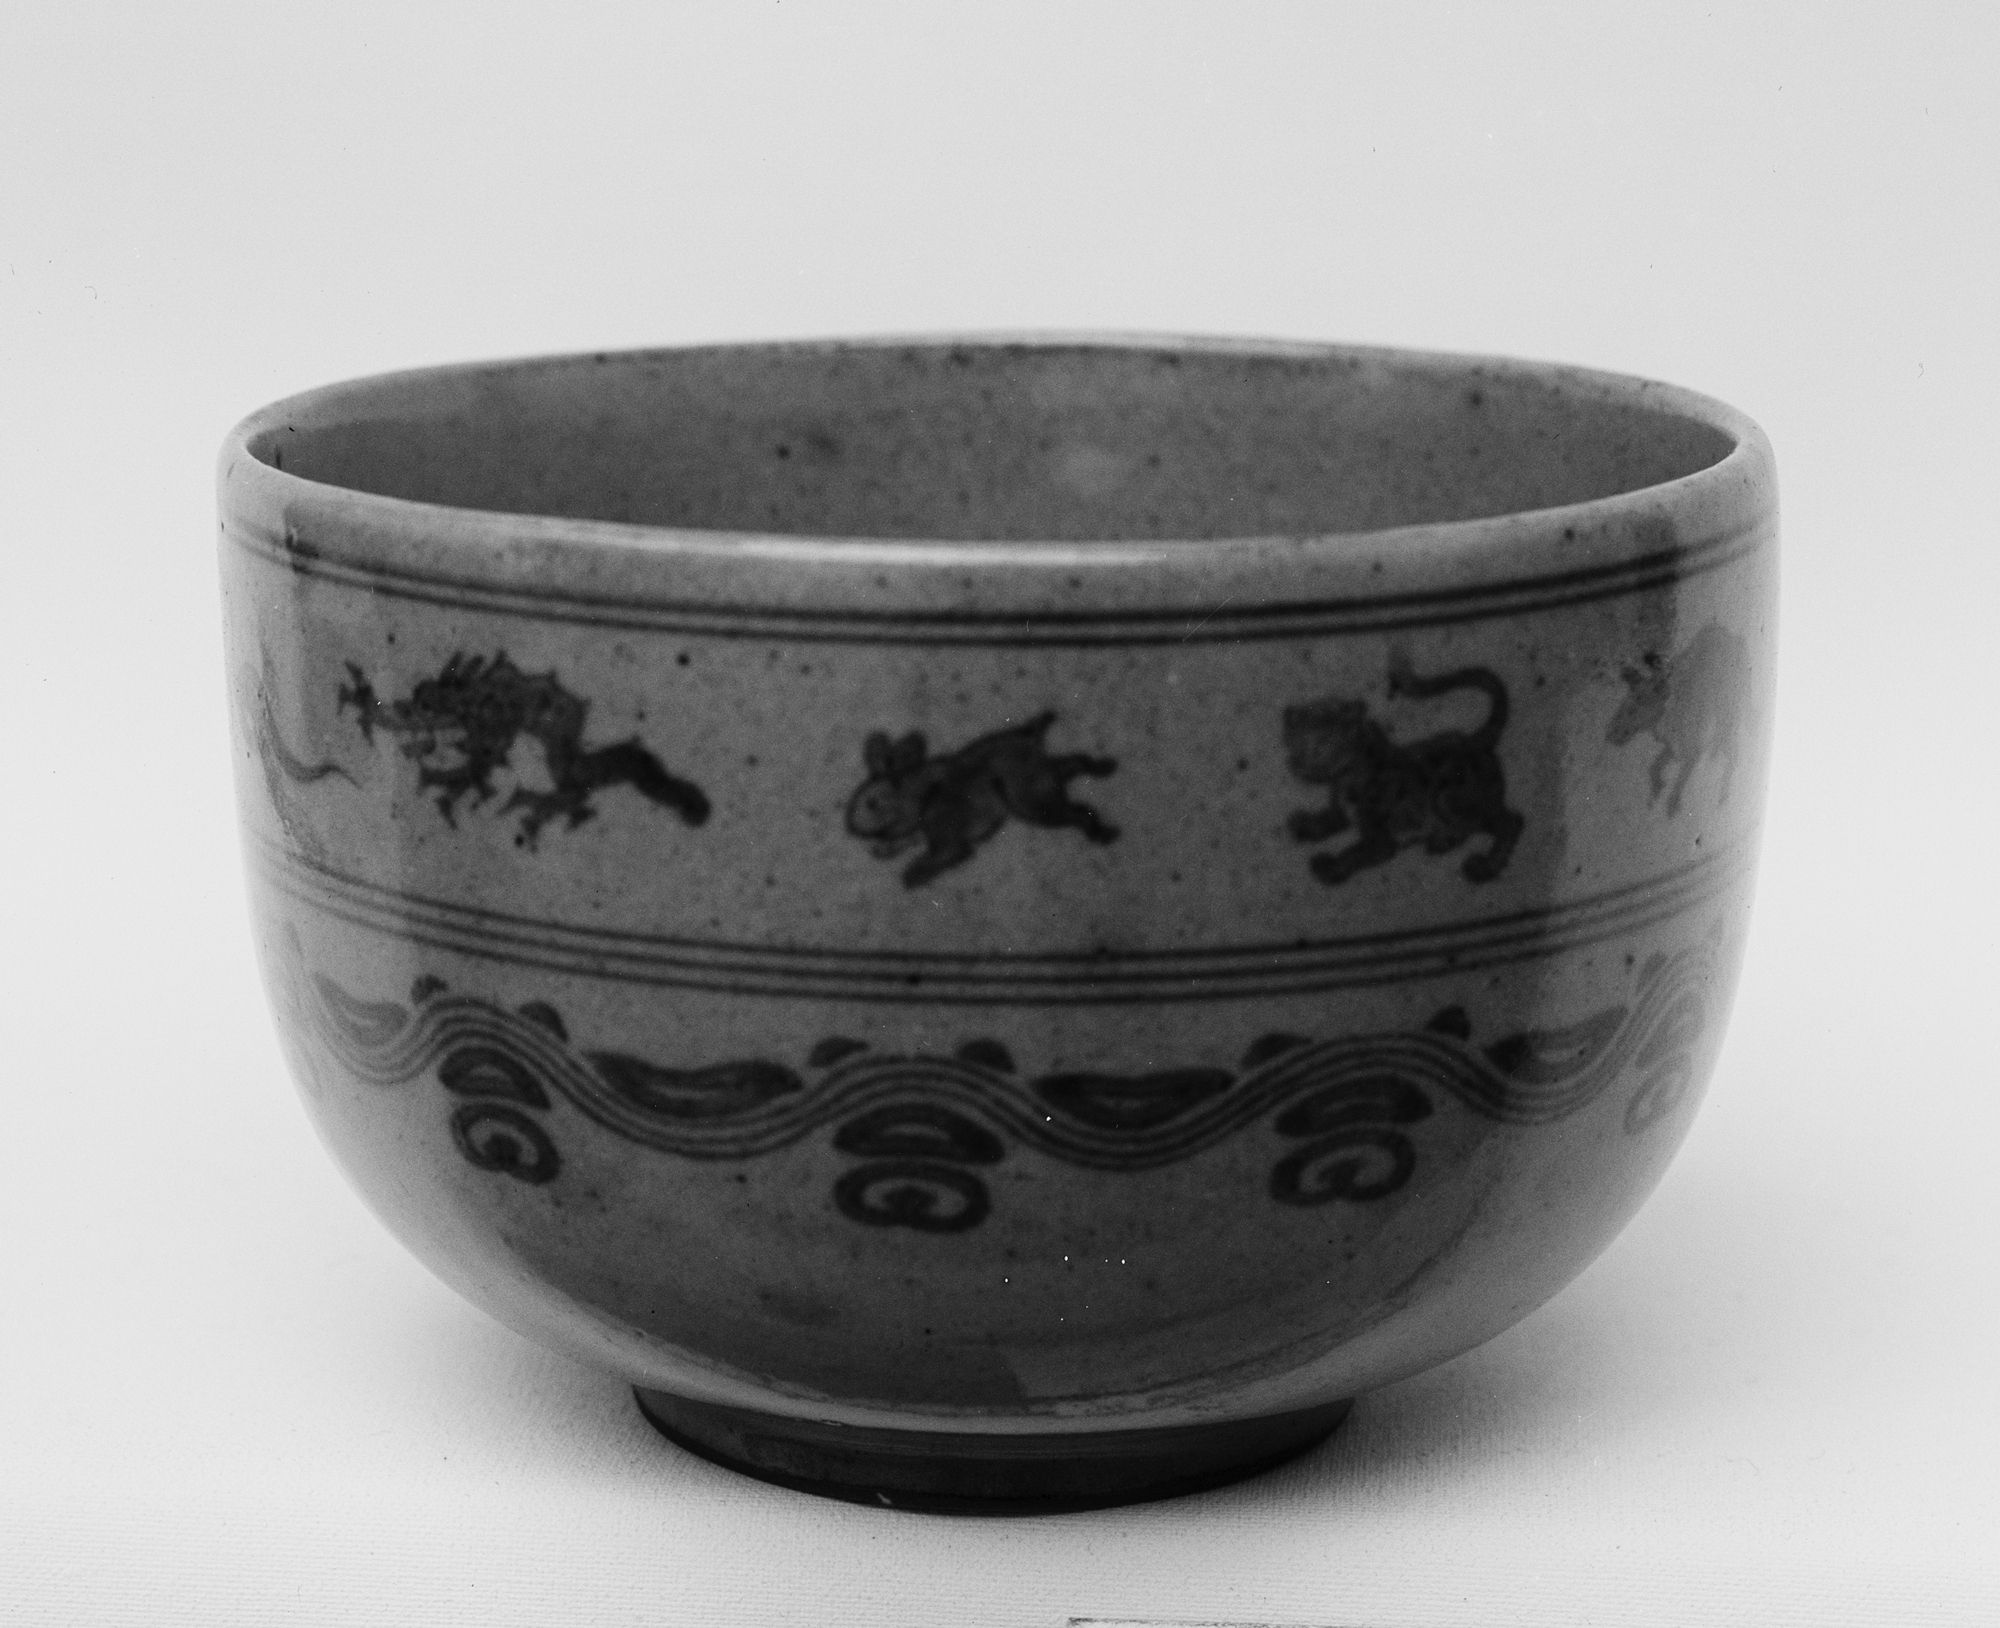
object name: cup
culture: japanese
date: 1650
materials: clay, glaze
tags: animals